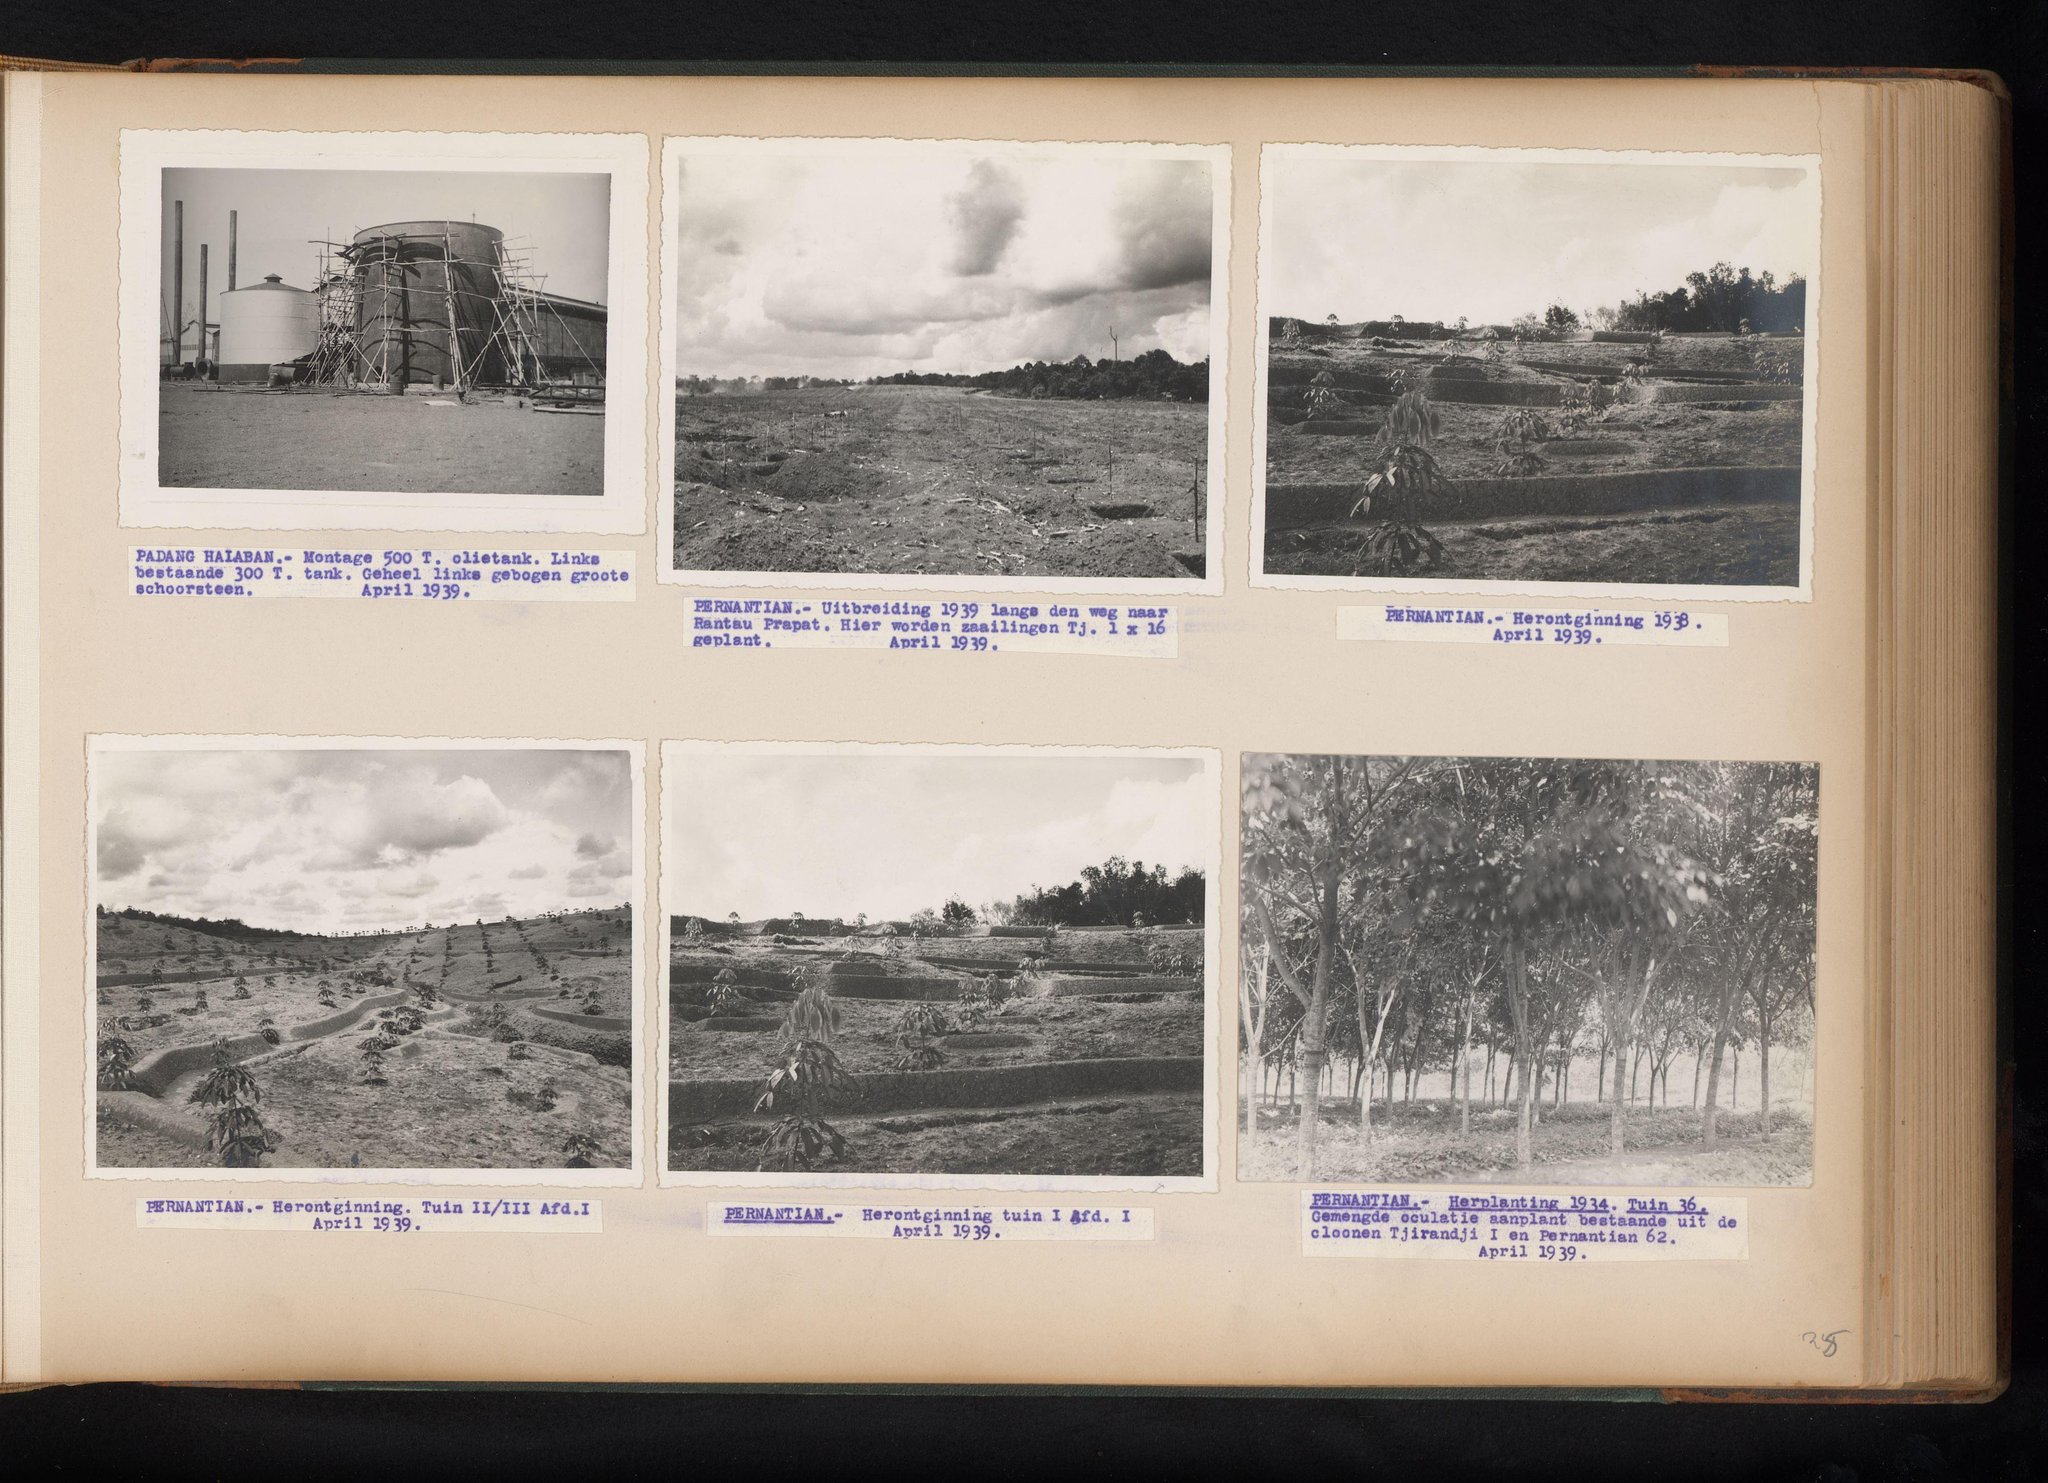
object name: album leaf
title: Olietank op Padang Halaban en herontginning op Pernantian, 1939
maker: Anonymous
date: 1904-1939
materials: cardboard, photographic support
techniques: gelatin silver print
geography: sumatra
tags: plantation, (non-fruit) products of plants or trees: rubber, (non-fruit) products of plants or trees: palm oil, exterior of industrial structures, factories, sumatra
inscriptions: inscription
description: Blad met zes foto's van een nieuwe olietank in de palmoliefabriek op Padang Halaban en van herontginning rubbervelden op Pernantian, april 1939. Met etiketten met onderschriften onder de foto's. Onderdeel van het fotoalbum over de plantages Pernantian en Brussel van de Sumatra Caoutchouc Maatschappij op de Oostkust van Sumatra in de jaren 1935-1939.